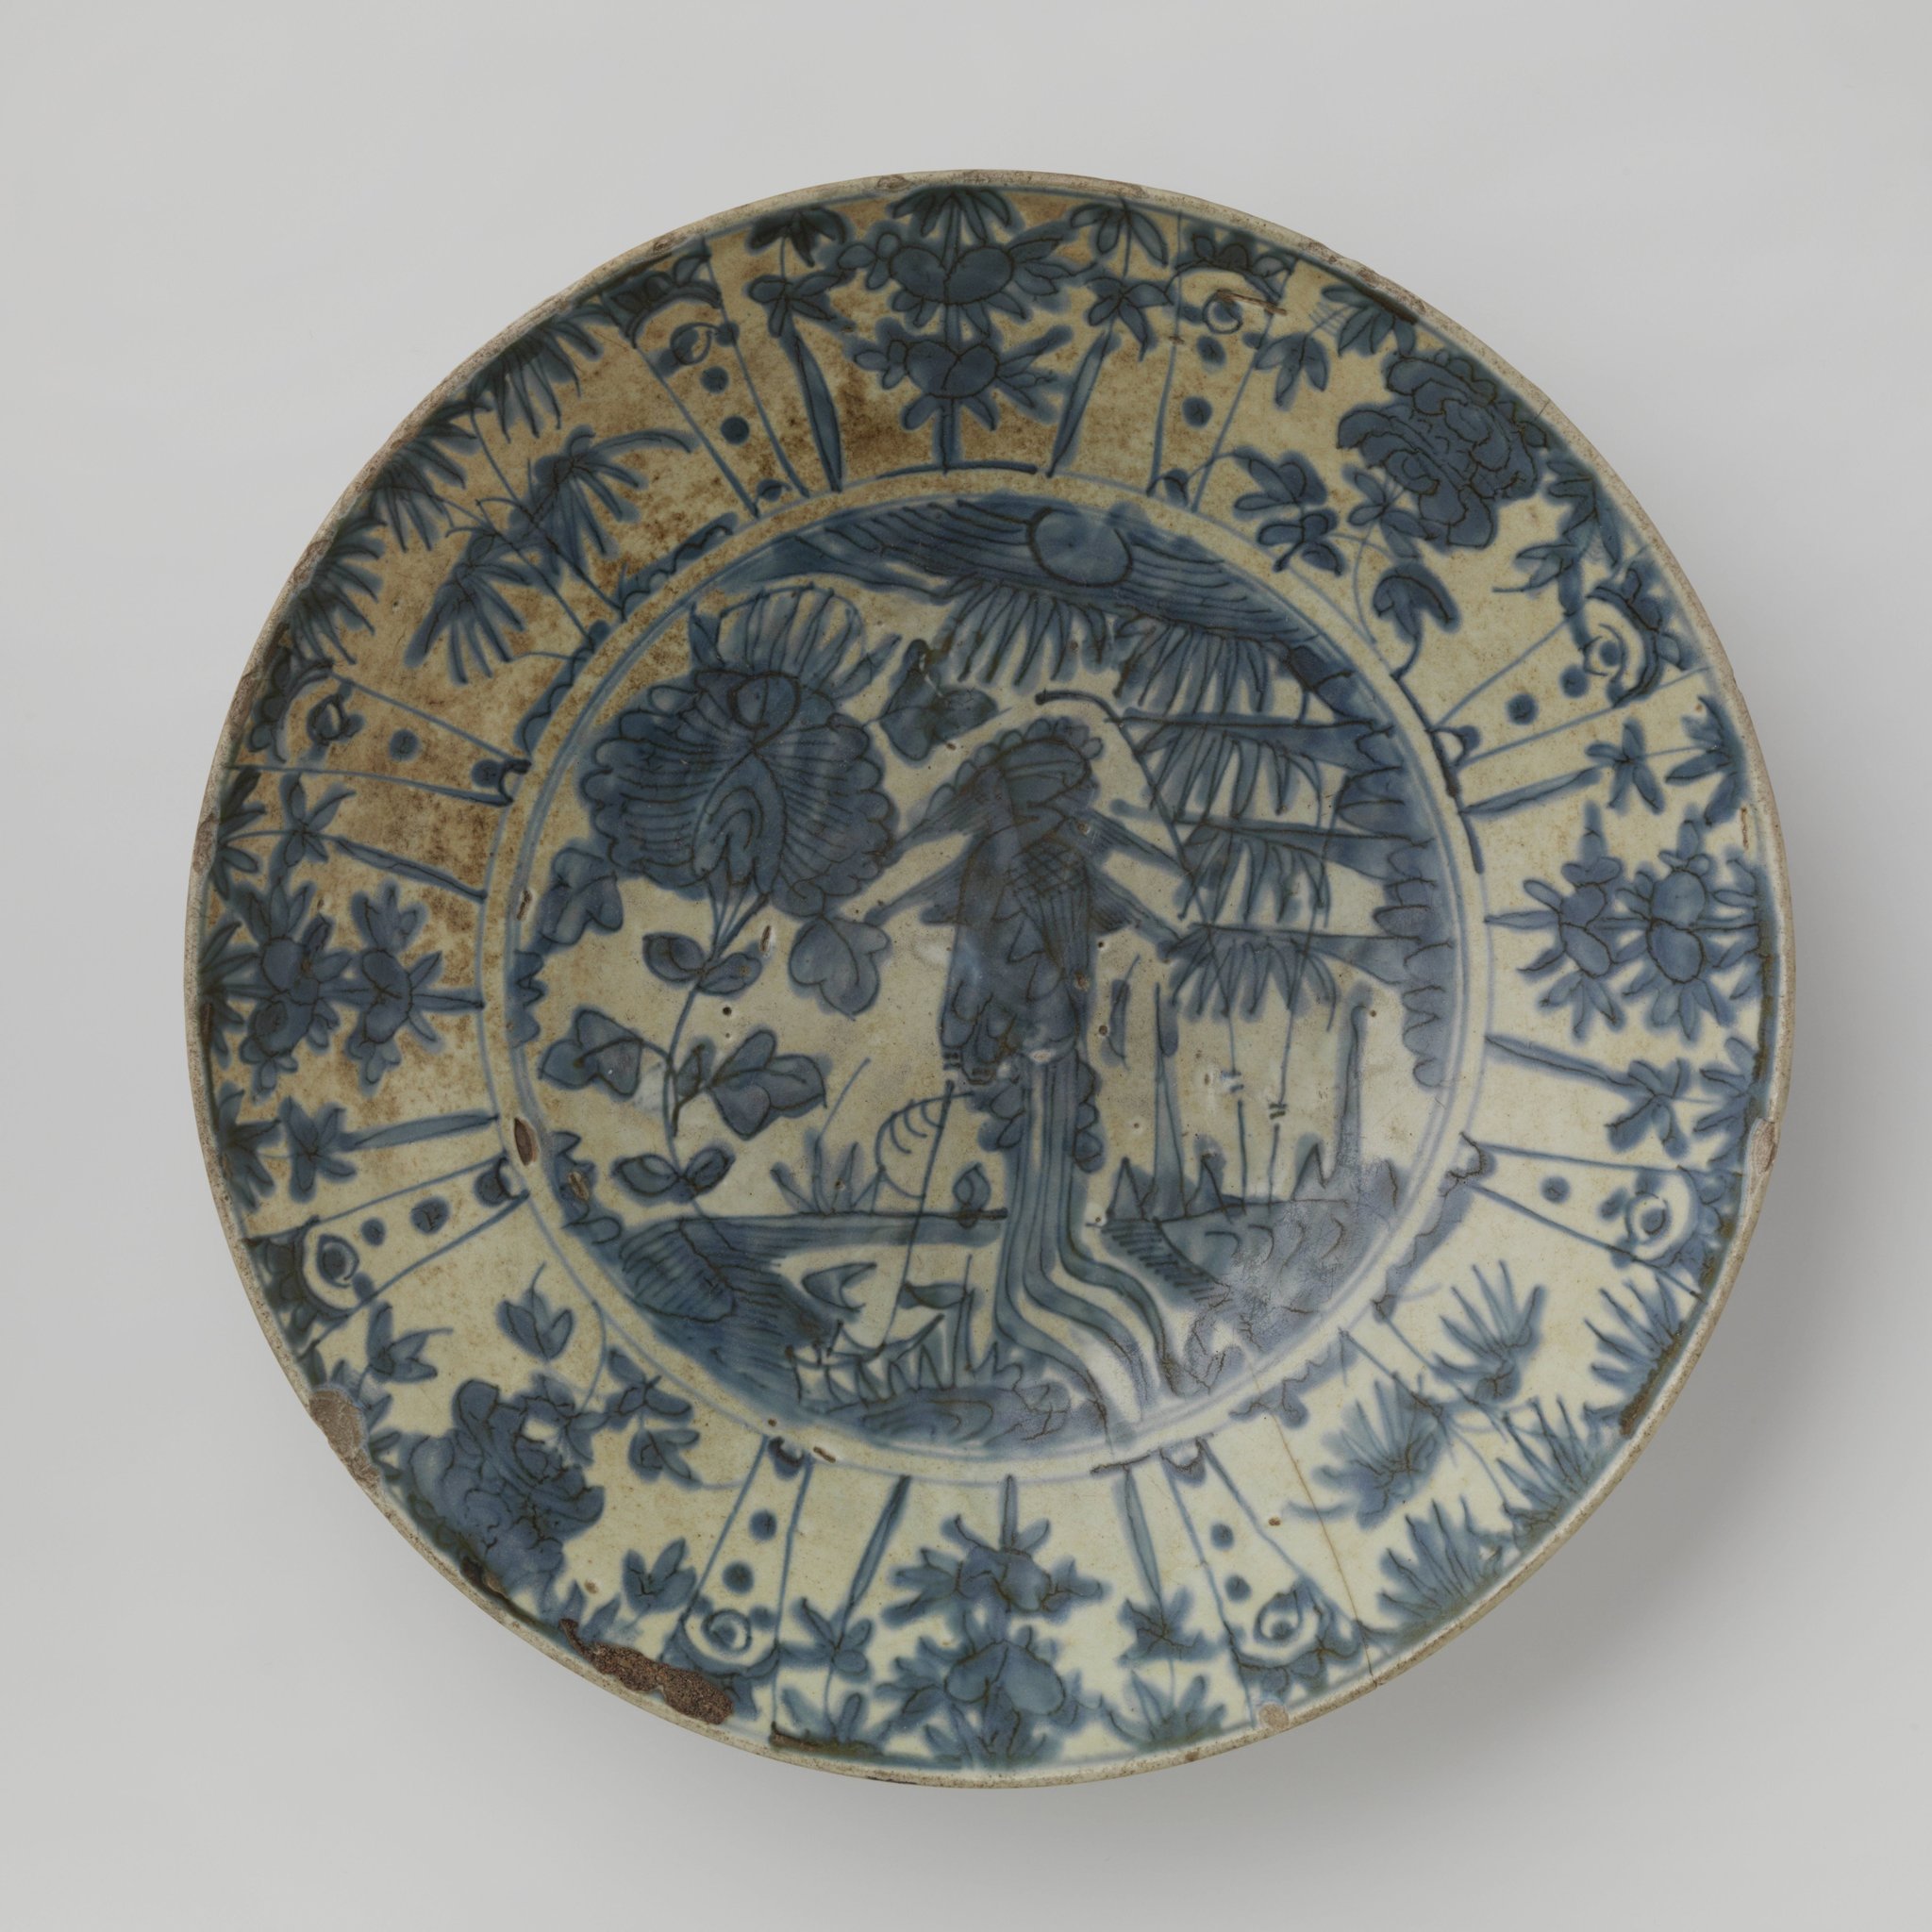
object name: platter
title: Saucer-dish with a fenghuang in a landscape and flowering plants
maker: Anonymous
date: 1600-1624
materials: cobalt, glaze, paint, porcelain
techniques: firing, turning, vitrification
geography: china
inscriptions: label: ‘4793/ 80,-’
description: Schotel, swatow, met op het plat een staande vogel.